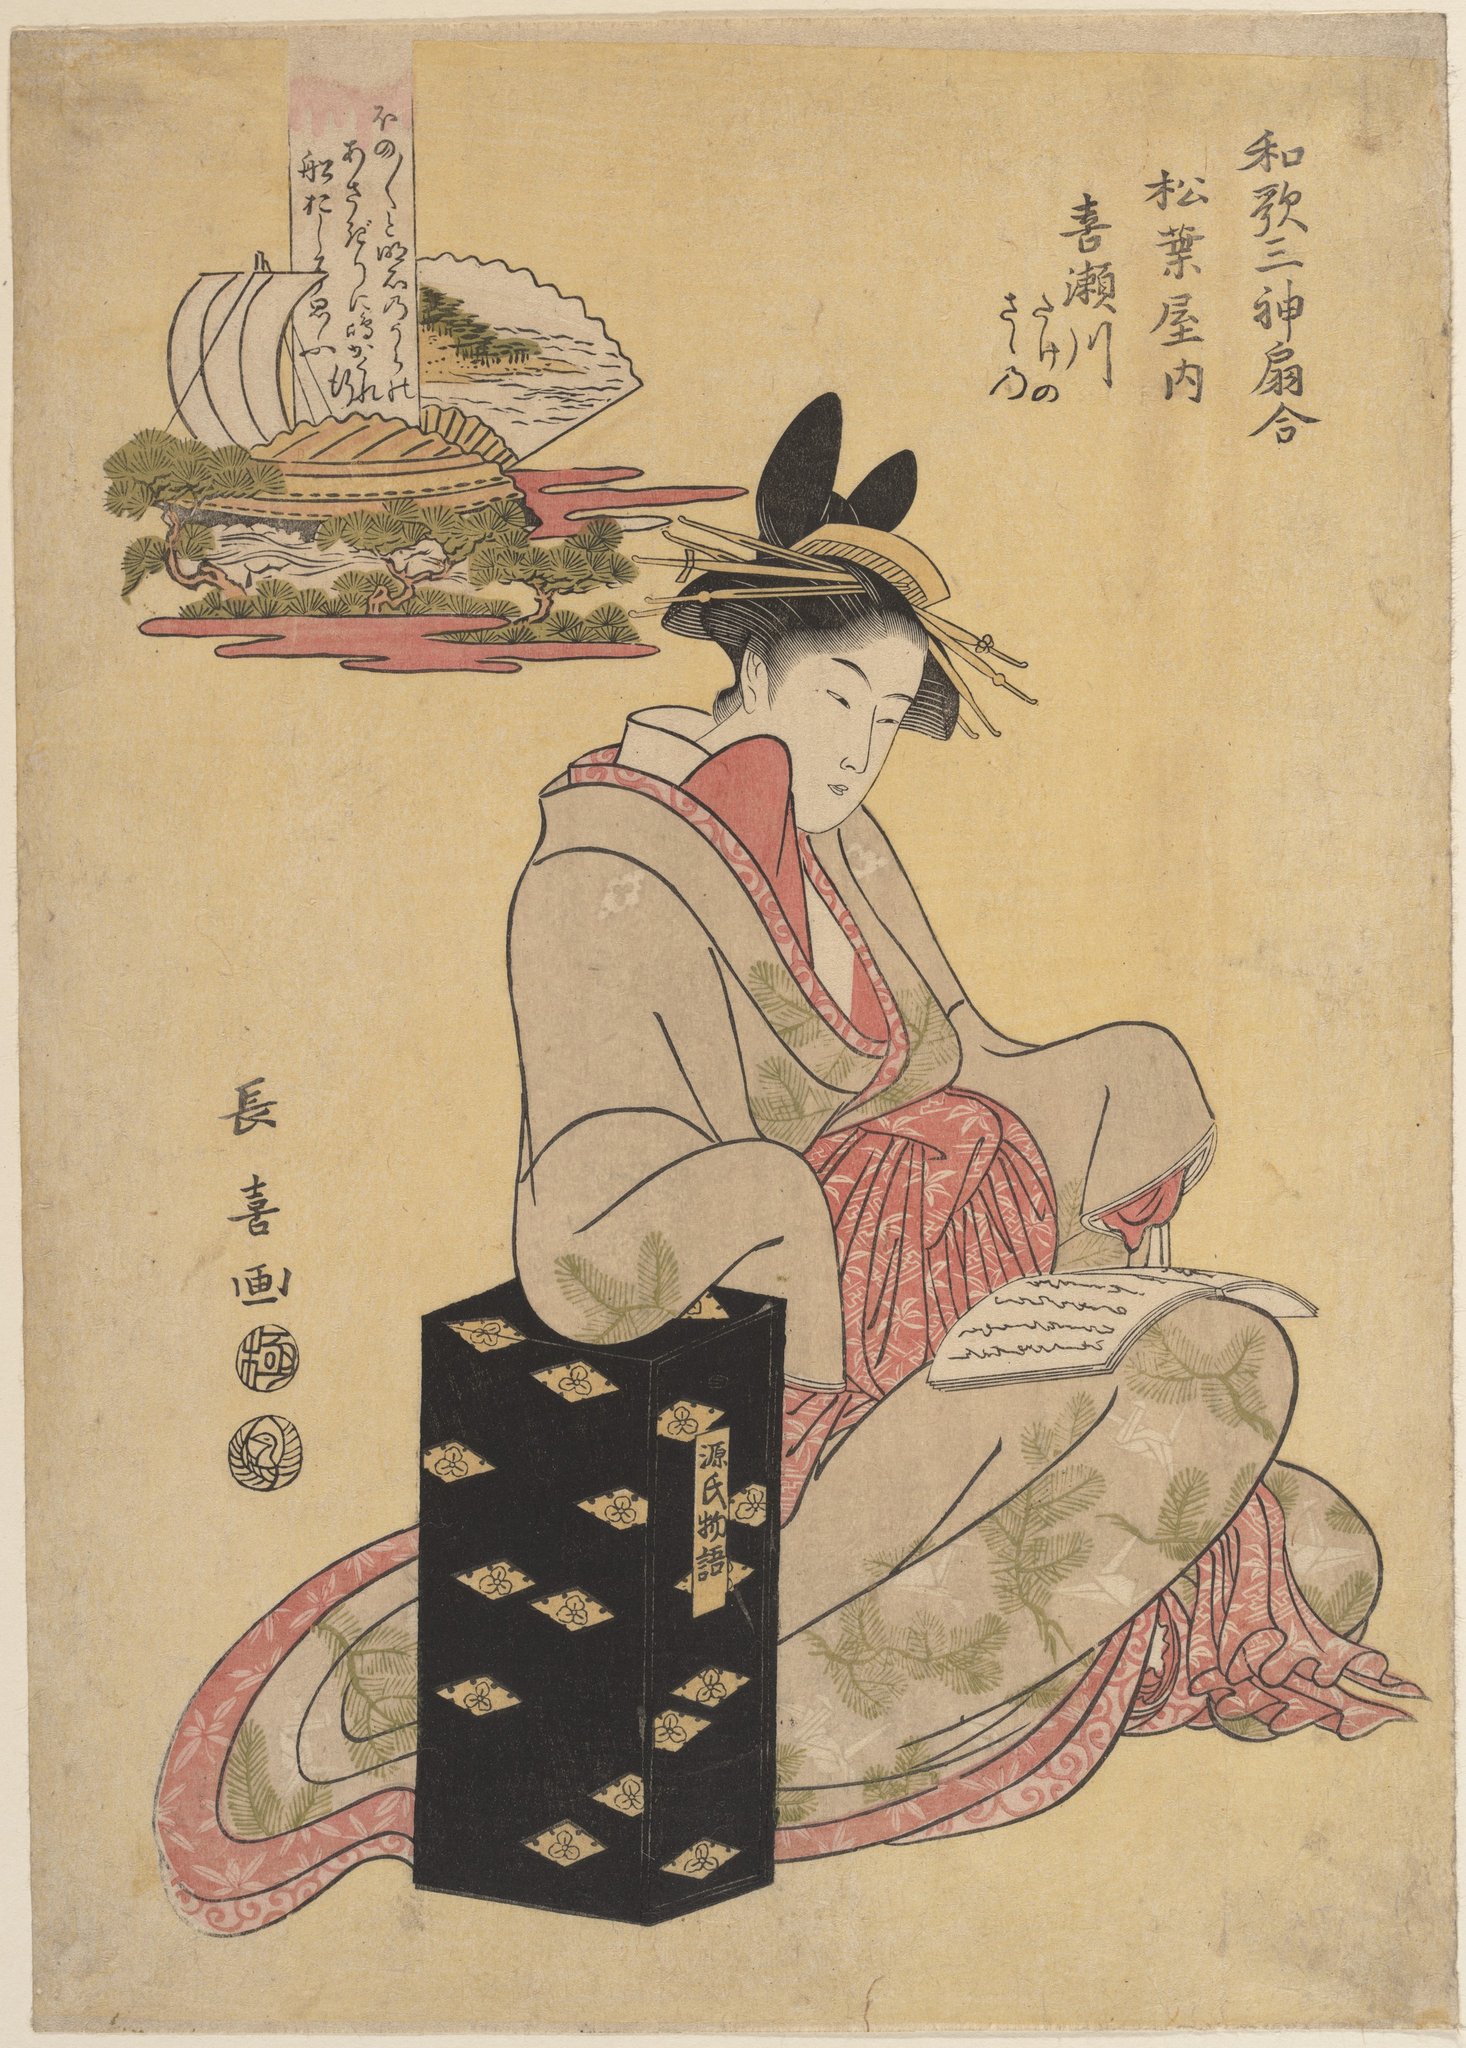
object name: print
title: The Courtesan Kisegawa of Matsubaya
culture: japanese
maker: eishōsai chōki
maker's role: artist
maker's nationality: japanese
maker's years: 1700-1900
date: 1796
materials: ink, paper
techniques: woodblock print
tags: women,reading,boats